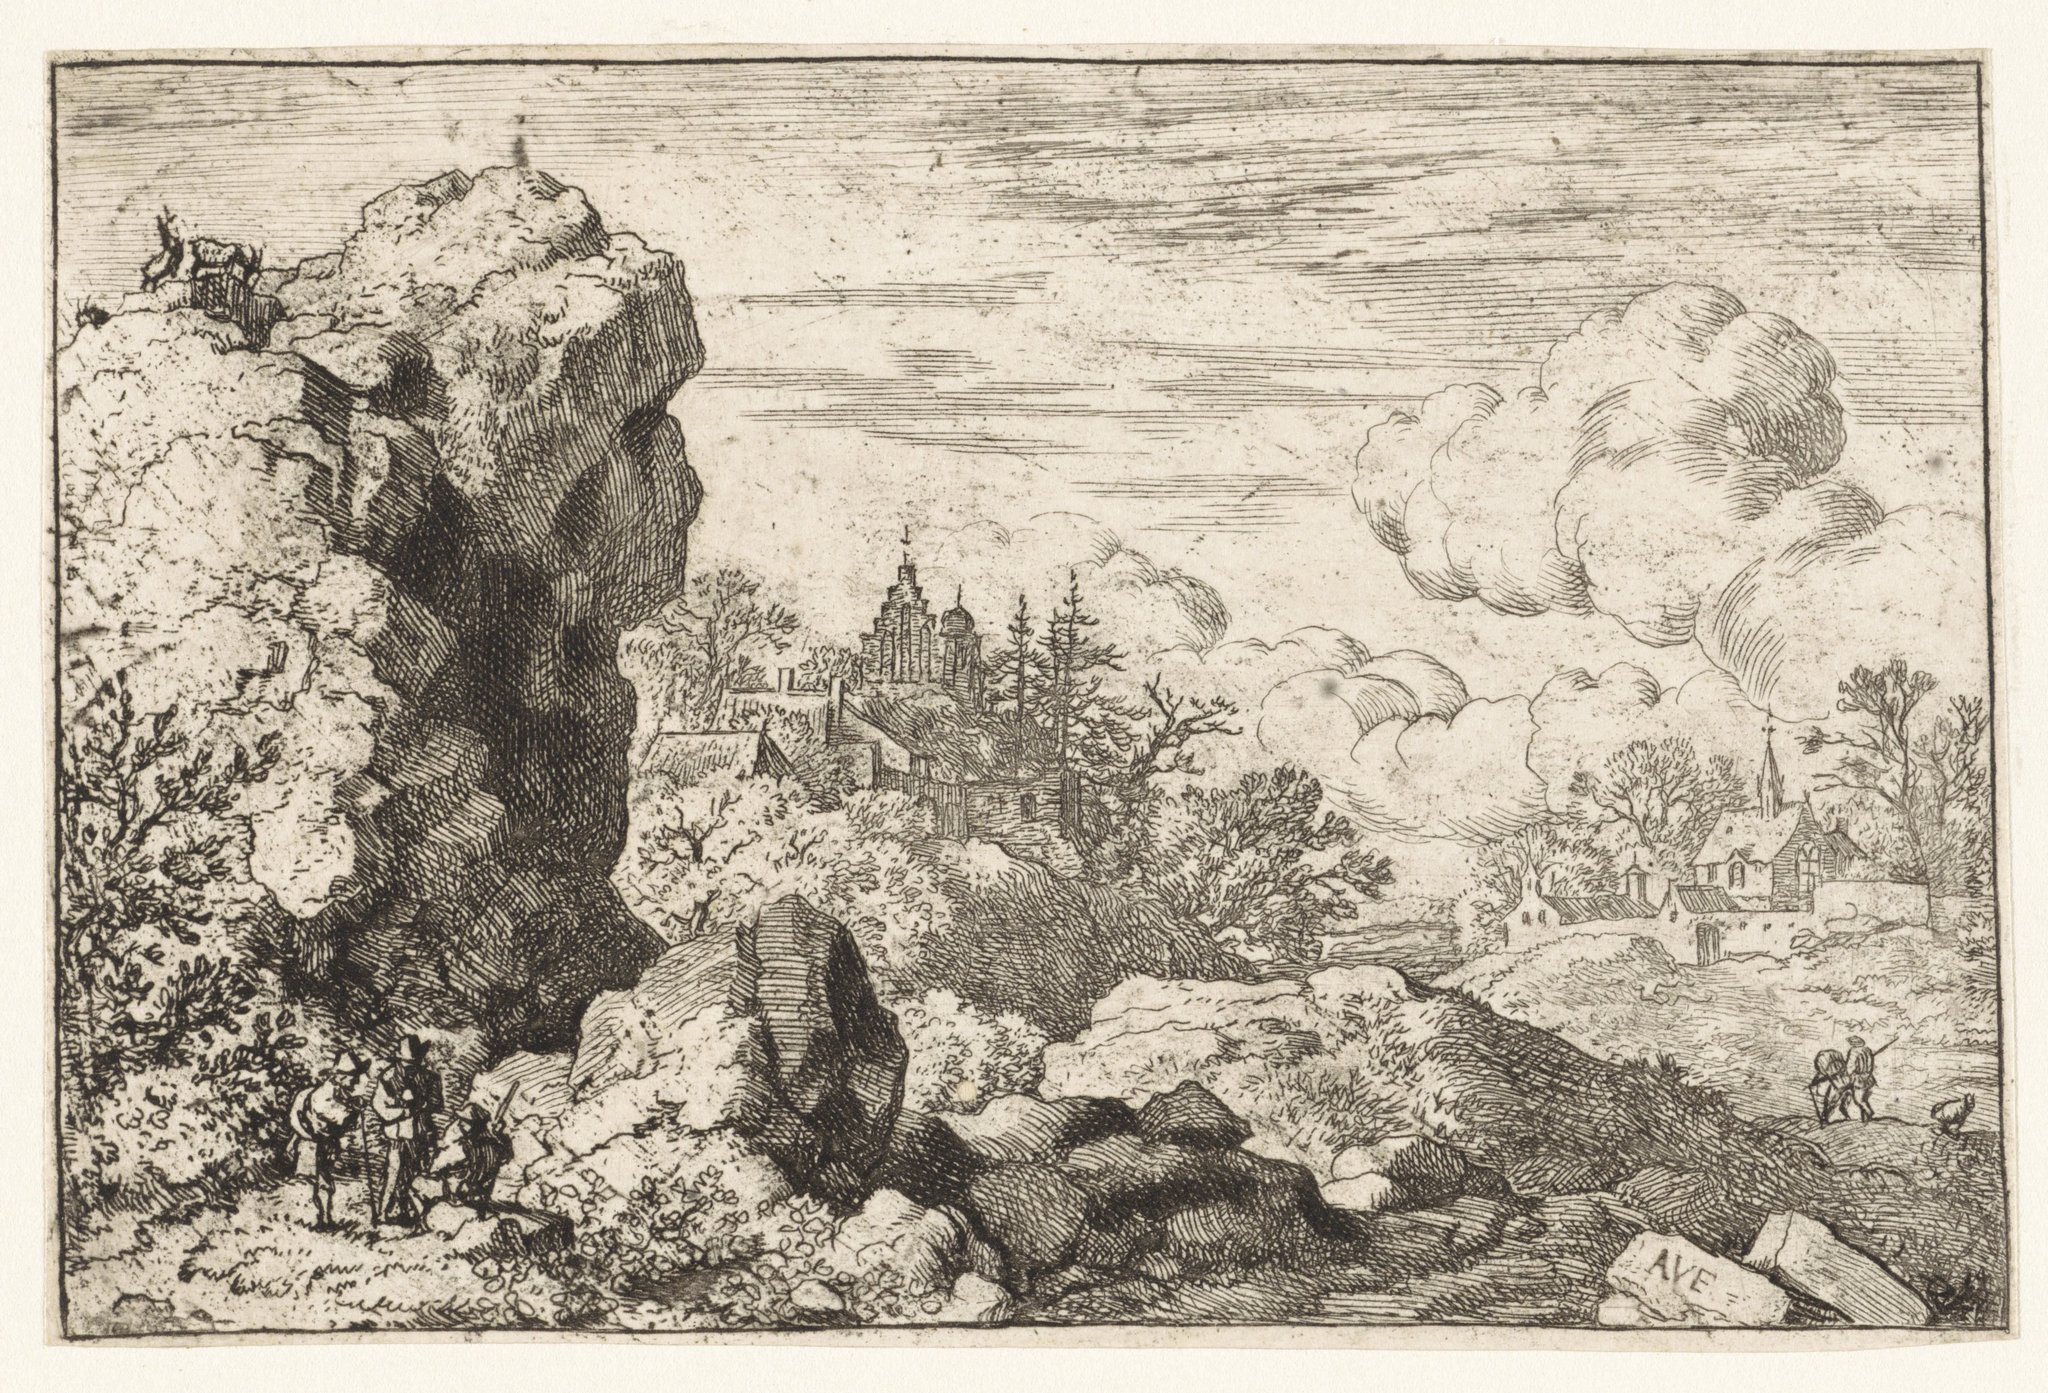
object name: print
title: Drie reizigers aan de voet van een rots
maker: allaert van everdingen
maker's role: draughtsman, painter, print maker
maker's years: 1621-1675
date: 1631-1675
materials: paper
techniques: etching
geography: netherlands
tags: rocks (+ landscape with figures, staffage)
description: Berglandschap met op de voorgrond drie personen onderaan een hoge rots. Op de achtergrond twee kerktorens.